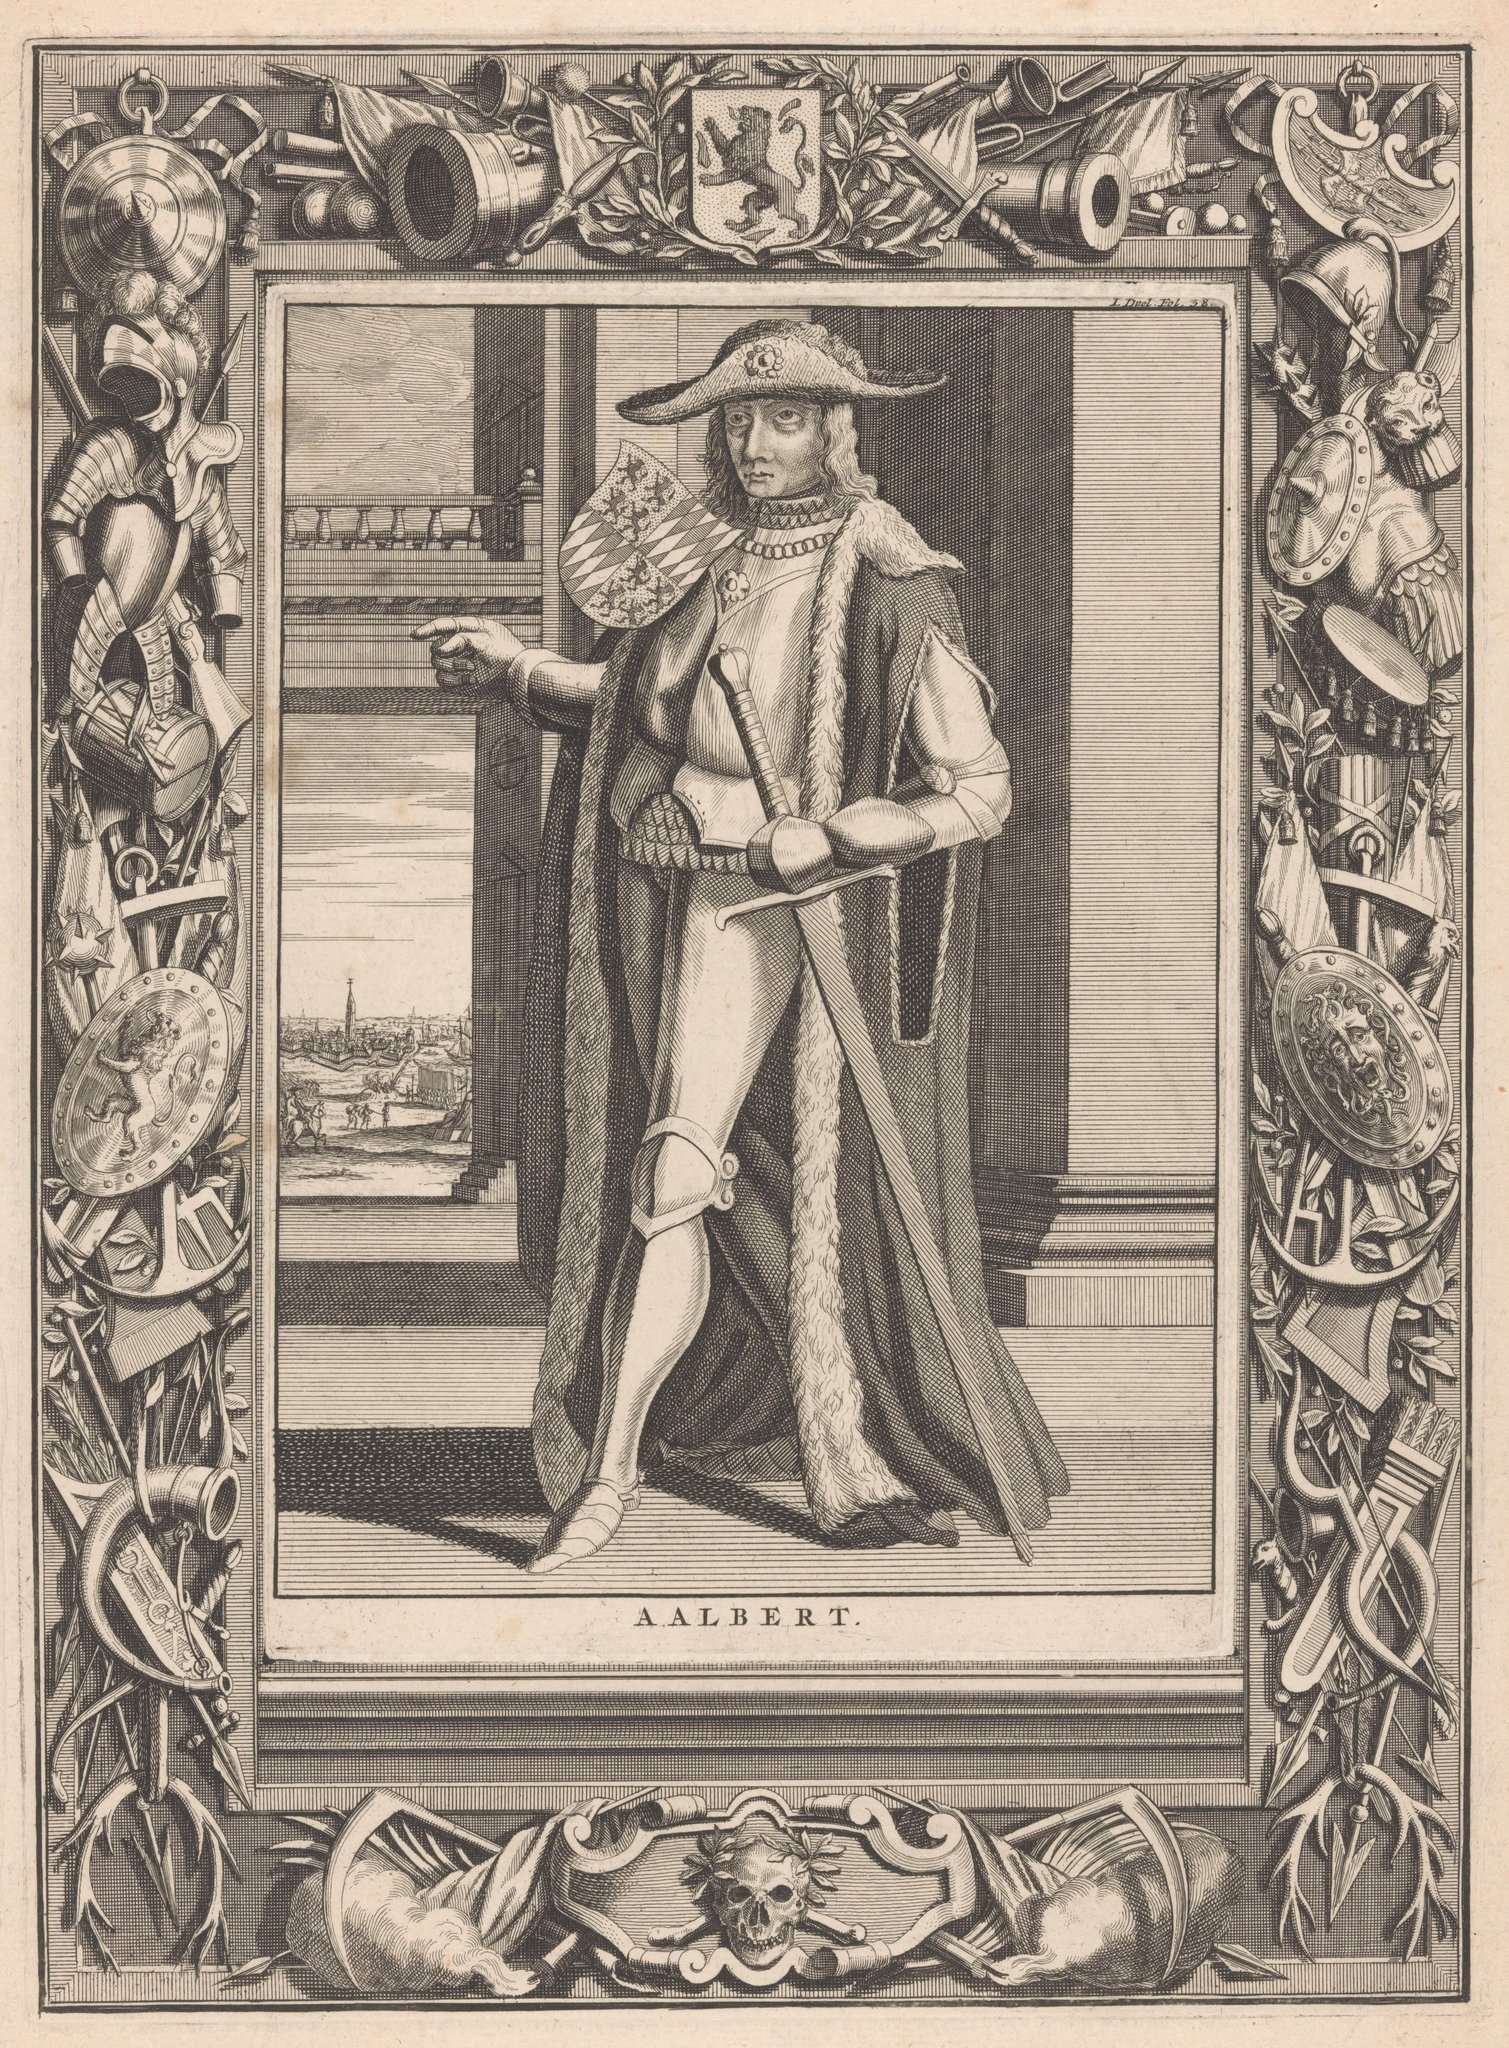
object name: print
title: Portret van Albrecht van Beieren, graaf van Holland, Henegouwen en Zeeland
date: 1725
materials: paper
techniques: engraving, etching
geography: leeuwarden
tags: duke of bavaria albert i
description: Portret van Albrecht van Beieren in een rechthoekige omlijsting. Linksboven zijn wapen. Op de achtergrond de belegering van een stad. In de ondermarge zijn naam. Rechtsboven: I. Deel. Fol. 38. Geheel in een afzonderlijk gegraveerde, rechthoekige omlijsting met een aantal allegorische objecten, waaronder wapentuig, een schedel en zijn wapen.